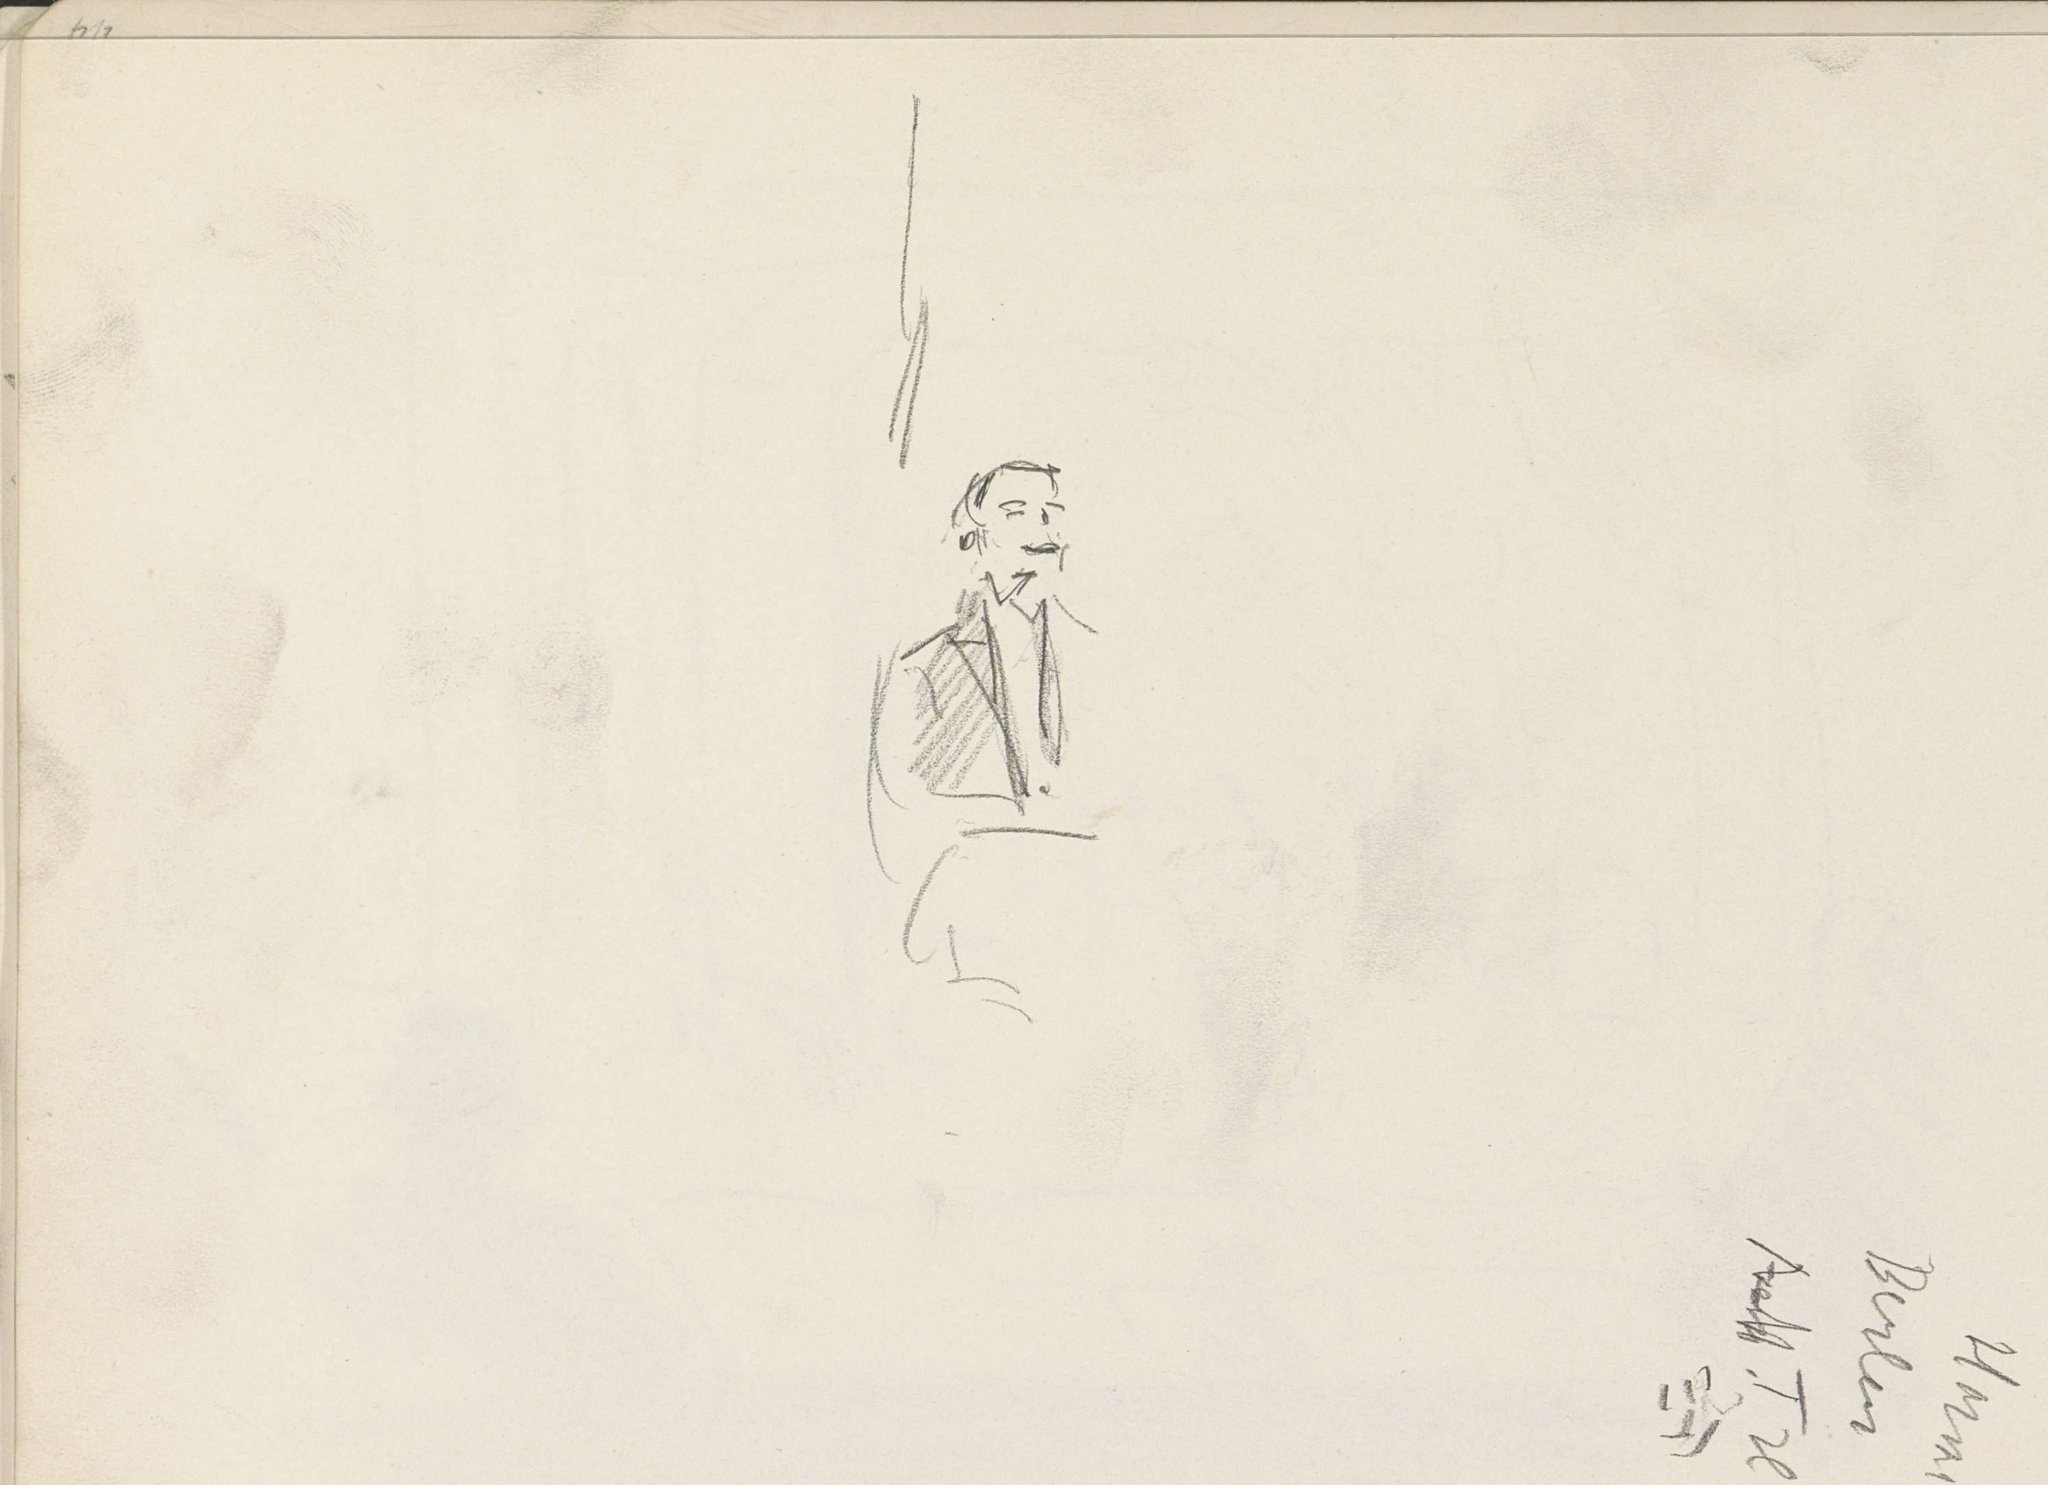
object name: sketchbook leaf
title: Man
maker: isaac israels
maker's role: draughtsman, painter, print maker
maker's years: 1865-1934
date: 1875-1934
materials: paper, pencil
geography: the hague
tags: adult man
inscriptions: annotation: ‘Harm[?] Beets / Berlin[?] 5036 / Tretoverpark [sic] 17’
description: Blad 23 verso uit schetsboek V met 33 bladen.